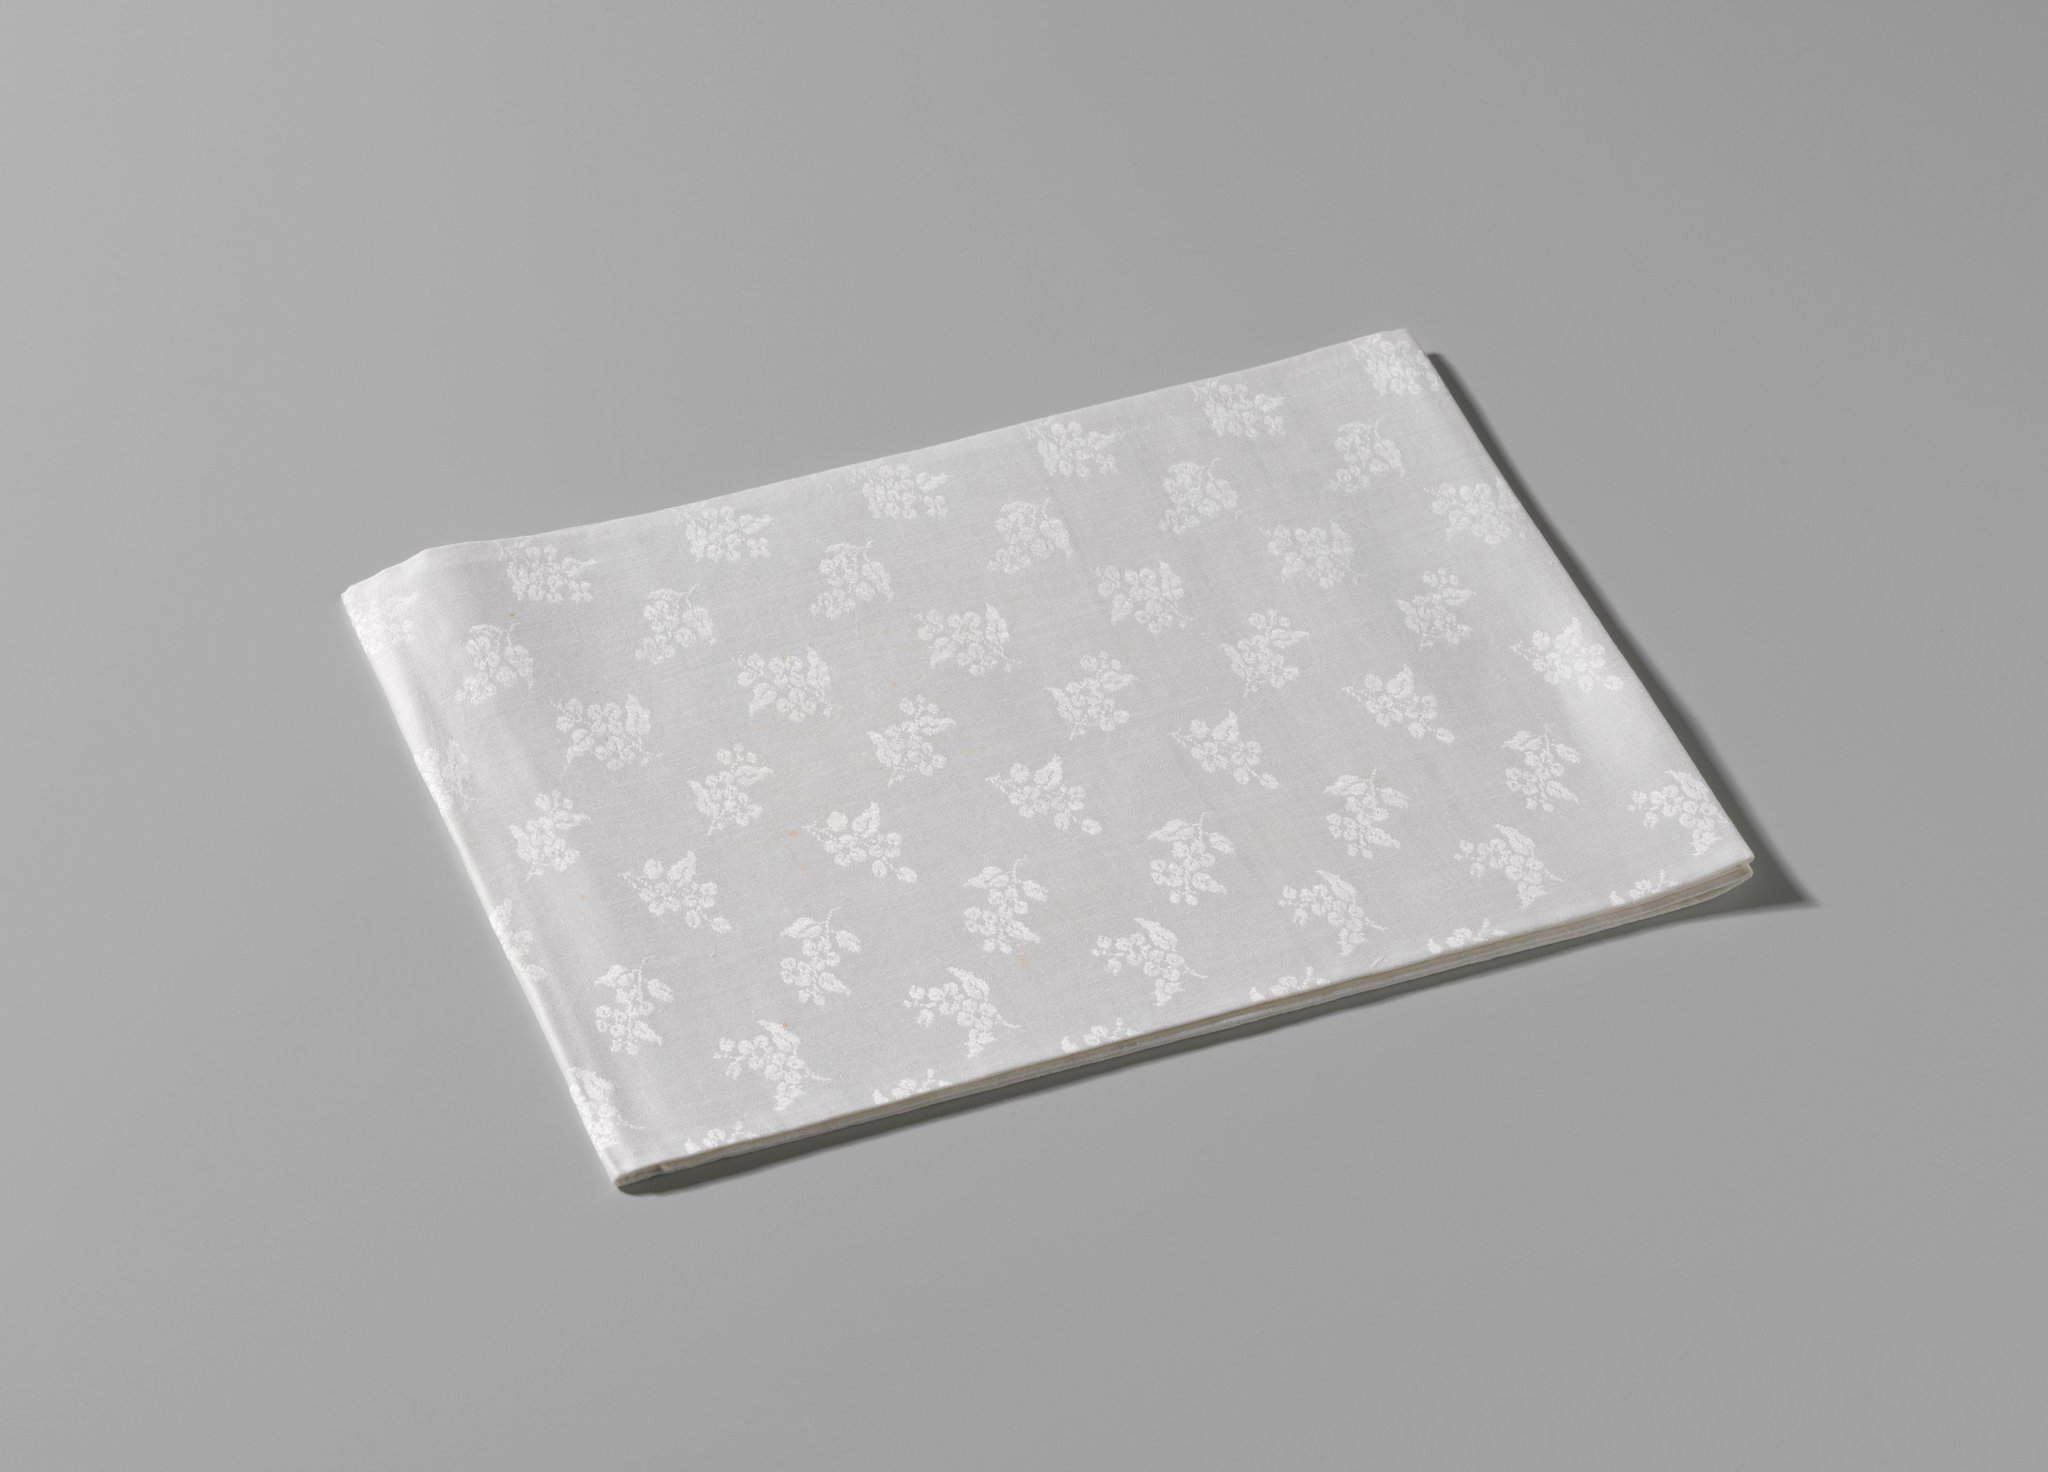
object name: napkin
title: Servet met strooibloemen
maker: Anonymous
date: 1700-1899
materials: linen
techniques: damask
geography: saxony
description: Vergelijk E. Kumsch, Leinendamastmuster des XVII. und XVIII. Jahrhunderts, Dresden 1891, Taf. 9,1.